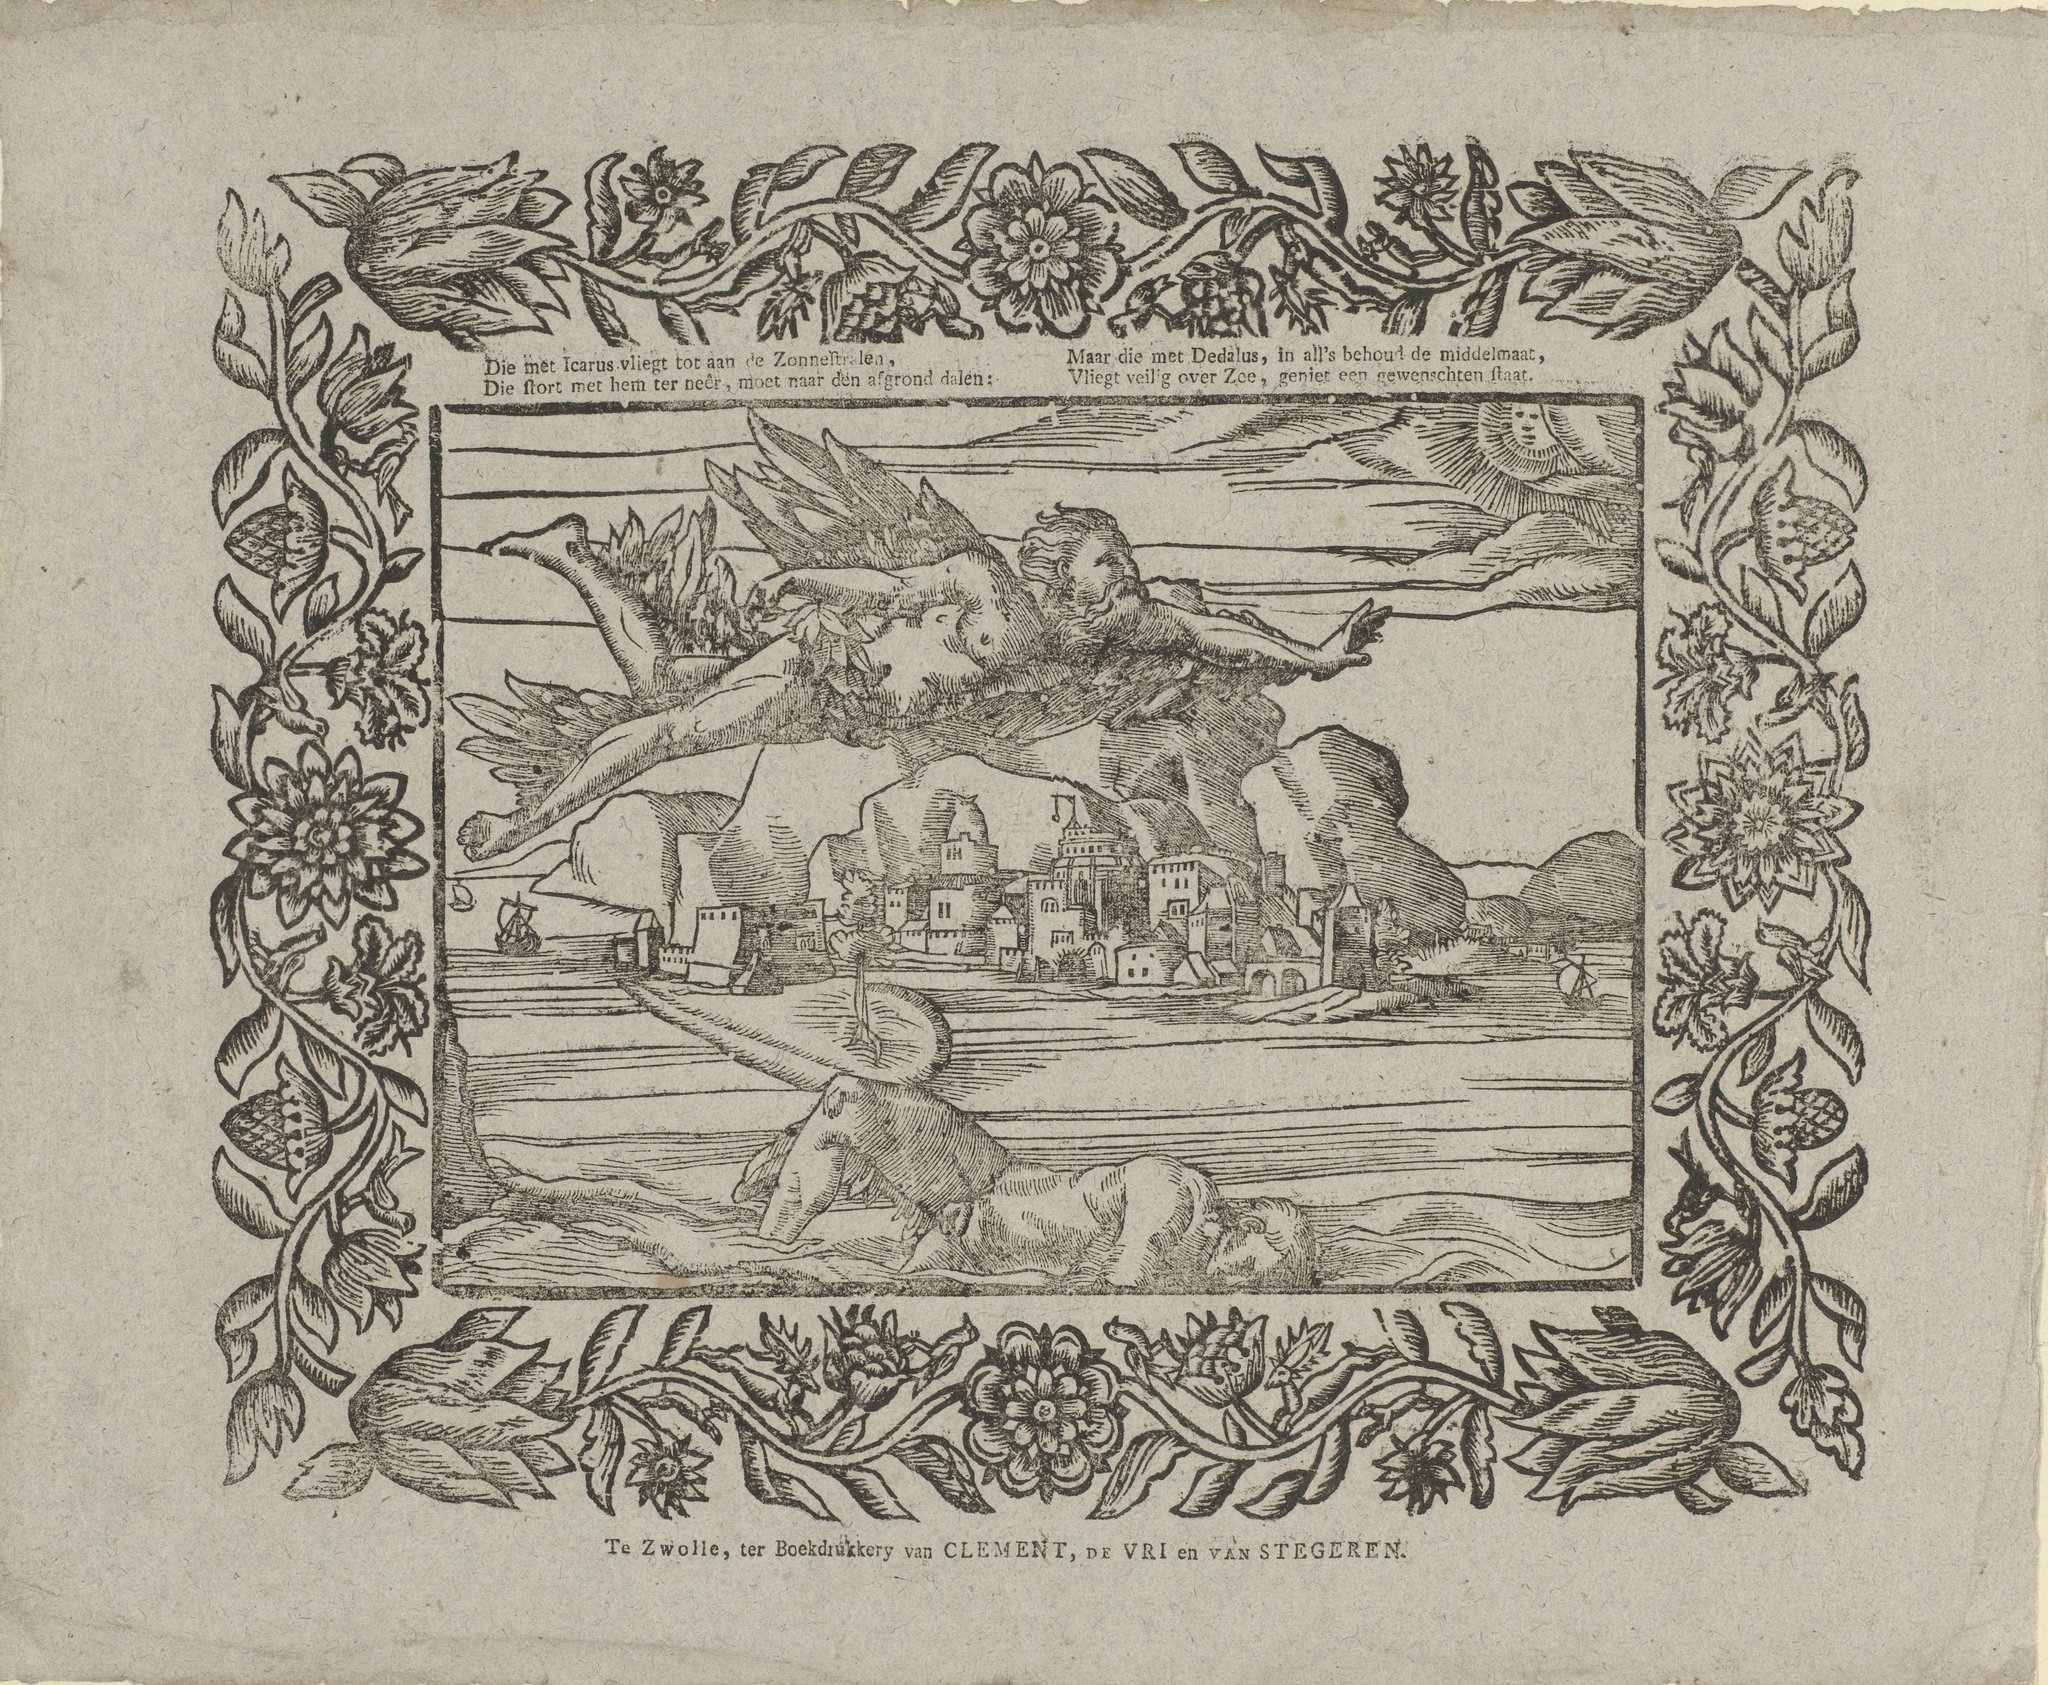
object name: print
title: Die met Icarus vliegt tot aan de Zonnestralen, / Die stort met hem ter neêr, moet naar den afgrond dalen; / Maar die met Dedalus, in all's behoud de middelmaat, / Vliegt veilig over zee, geniet een gewenschten staat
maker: Anonymous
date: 1816-1836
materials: paper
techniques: letterpress printing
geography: zwolle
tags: (story of) daedalus, (story of) icarus, son of daedalus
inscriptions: collector's mark: Lugt 2760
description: Daedalus vliegt door de lucht. Boven hem de zon, onder hem de zee. Zijn zoon Icarus verdrinkt in het water omdat hij te dicht bij de zon heeft gevlogen. Omgeven door een lijst van bloemenranken.